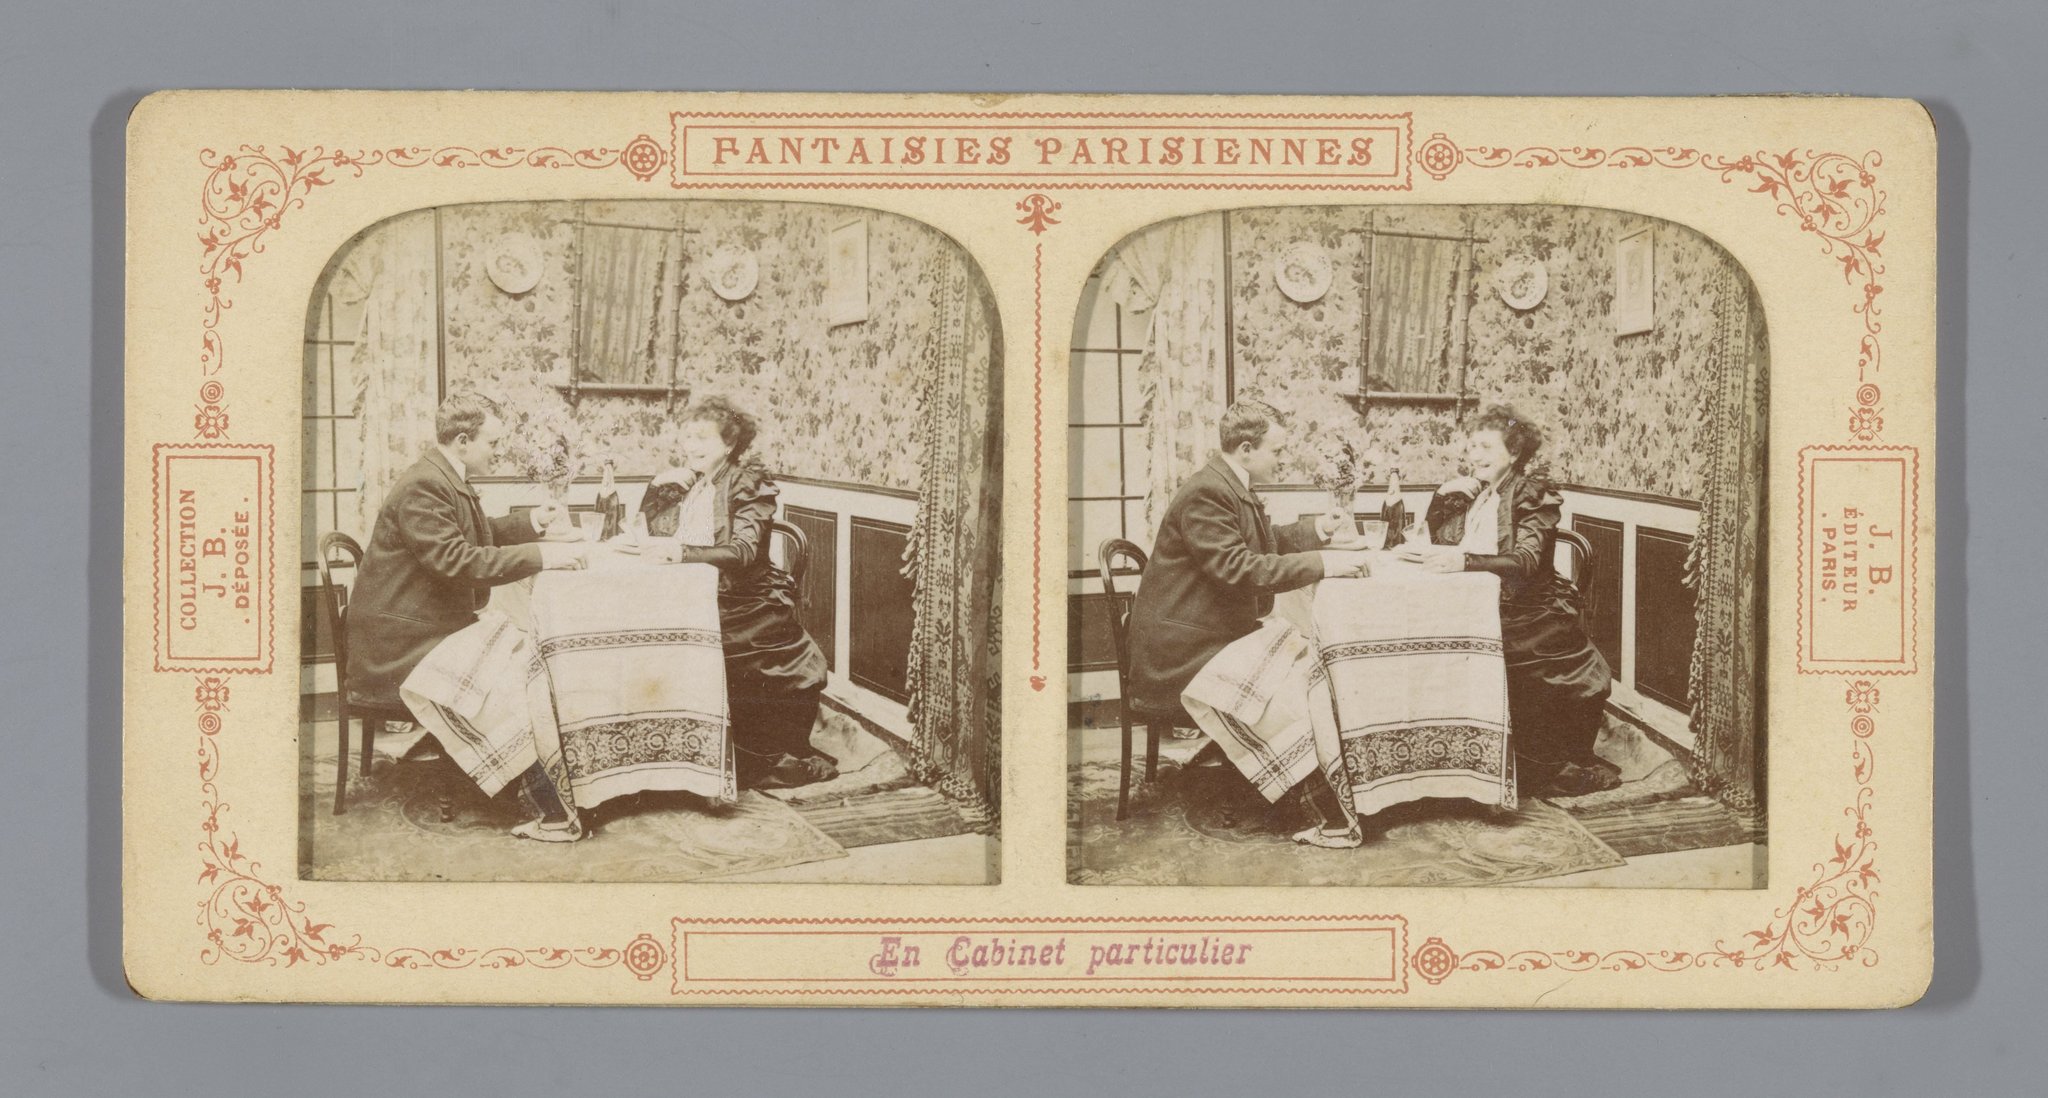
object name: tissue stereograph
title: Man en vrouw tijdens een maaltijd, gezeten aan tafel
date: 1855-1875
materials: cardboard, paper, photographic support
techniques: albumen print, hand coloring, perforating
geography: paris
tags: evening meal, dinner, supper, paris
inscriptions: number: ‘3457’, inscription: ‘DÉPOSÉE’